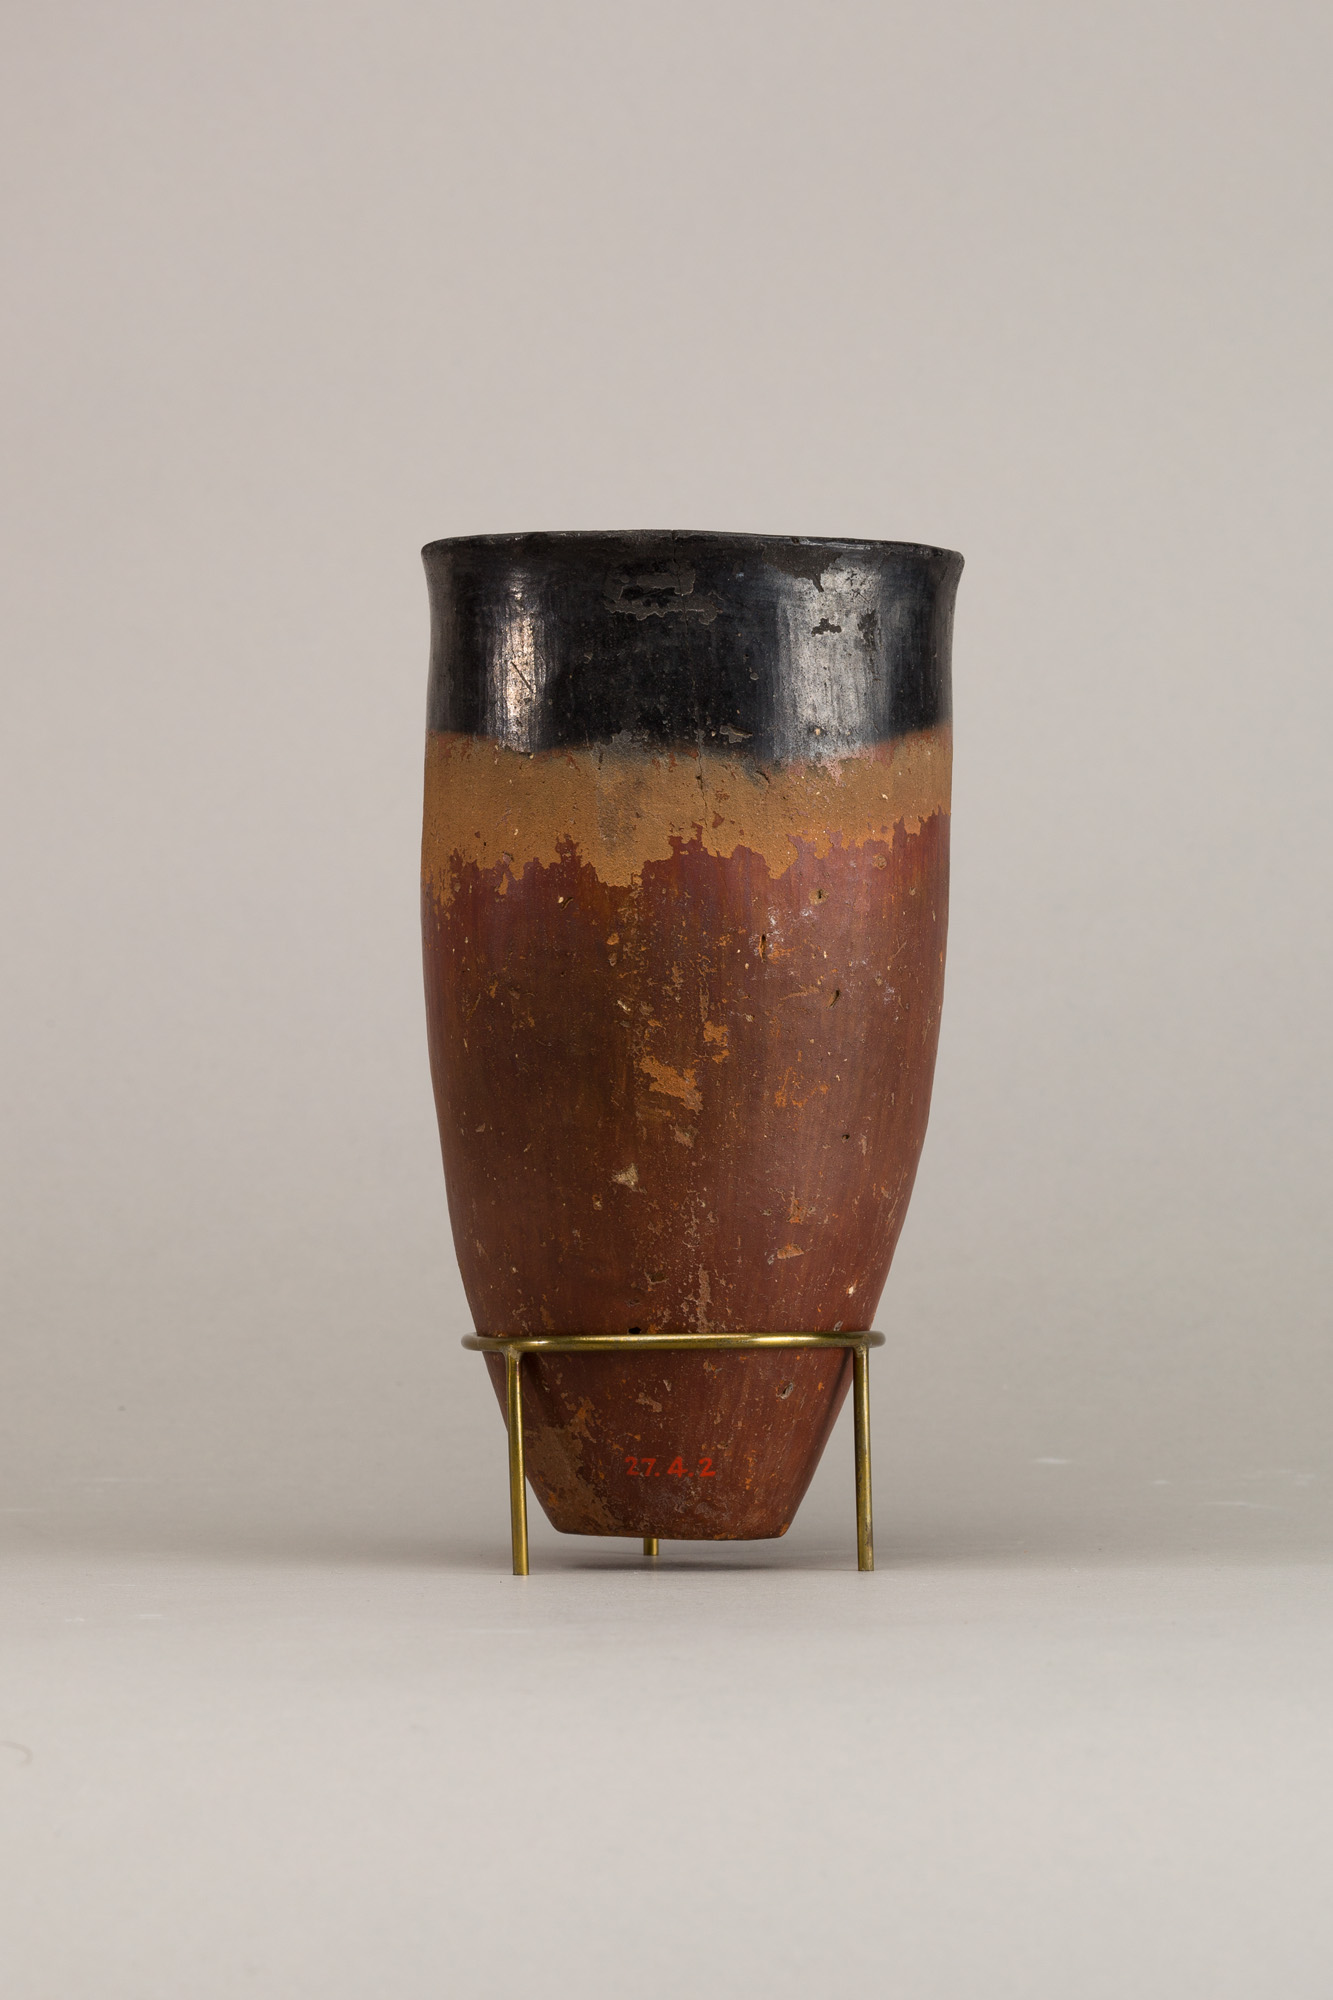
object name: beaker, black topped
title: Black-topped red ware beaker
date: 3850-2960 BCE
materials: pottery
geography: egypt